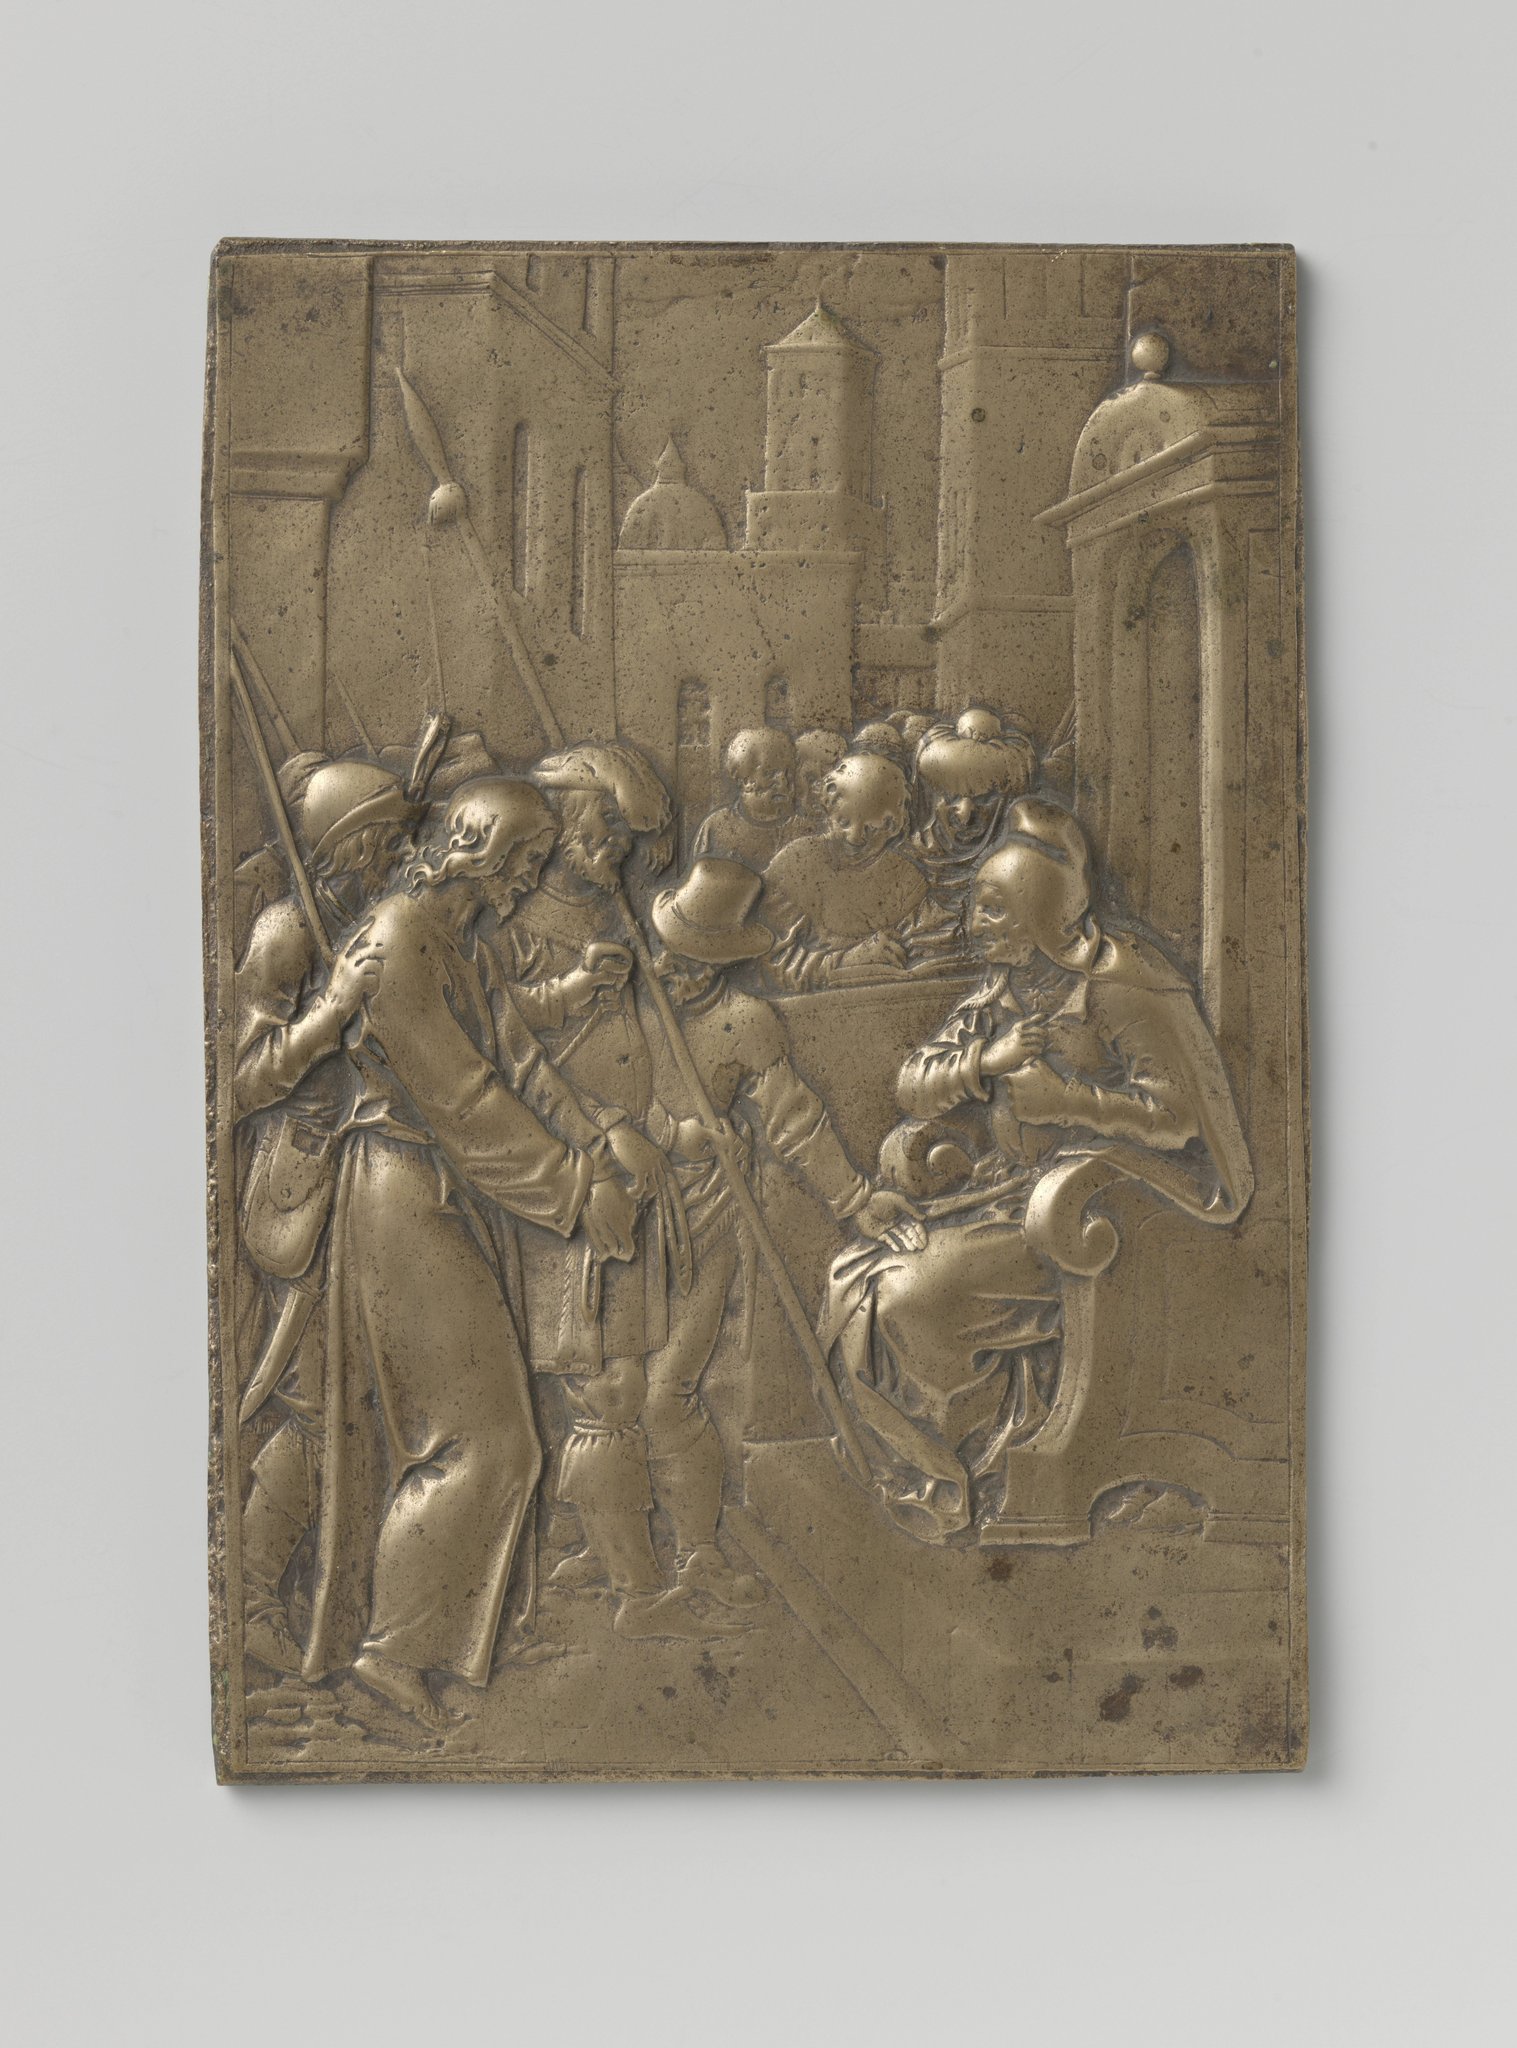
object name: plaque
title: De koperen passie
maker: arent van bolten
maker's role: draughtsman, print maker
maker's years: 1573-1633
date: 1600-1625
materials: bronze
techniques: gilding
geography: northern netherlands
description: Rechthoekige, verguld bronzen plaquette met Jezus, gebonden voor de Priester.